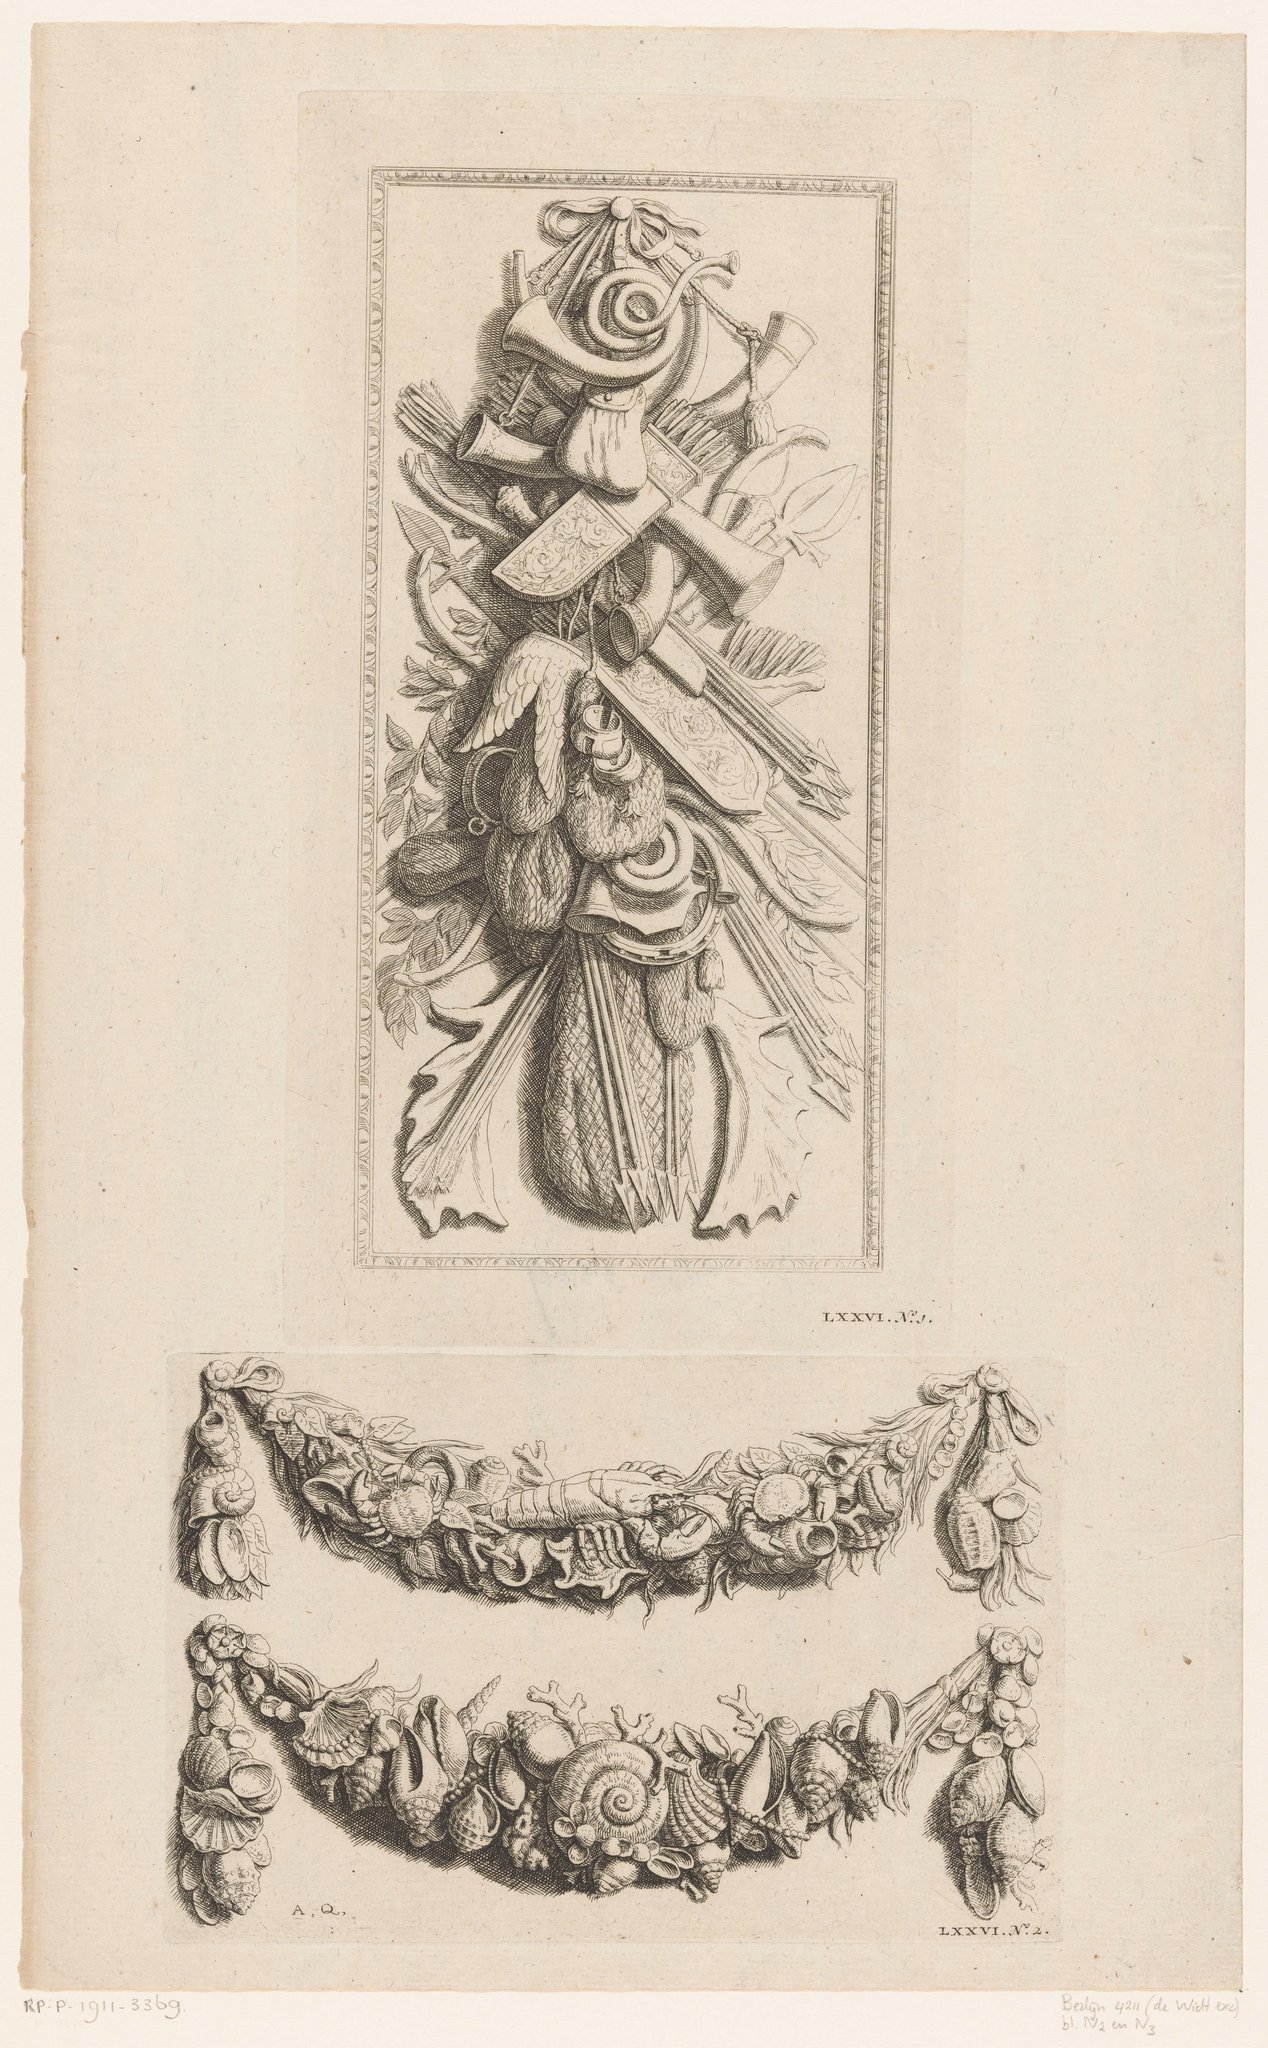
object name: ornament print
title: Jachttrofee en guirlandes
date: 1719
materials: paper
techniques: etching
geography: amsterdam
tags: ornament ~ festoon, garland, hunting trophies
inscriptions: collector's mark: Lugt 2228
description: Twee ornamenten op één blad. Boven: Een jachttrofee met attributen zoals een jachthoorn, pijlen en pijlenkokers, netten en een gewei. Blad LXXVI, No 1. Rondom een eierlijst. Onder: Twee guirlandes met schelpen en zeedieren. Blad LXXVI, No 2.